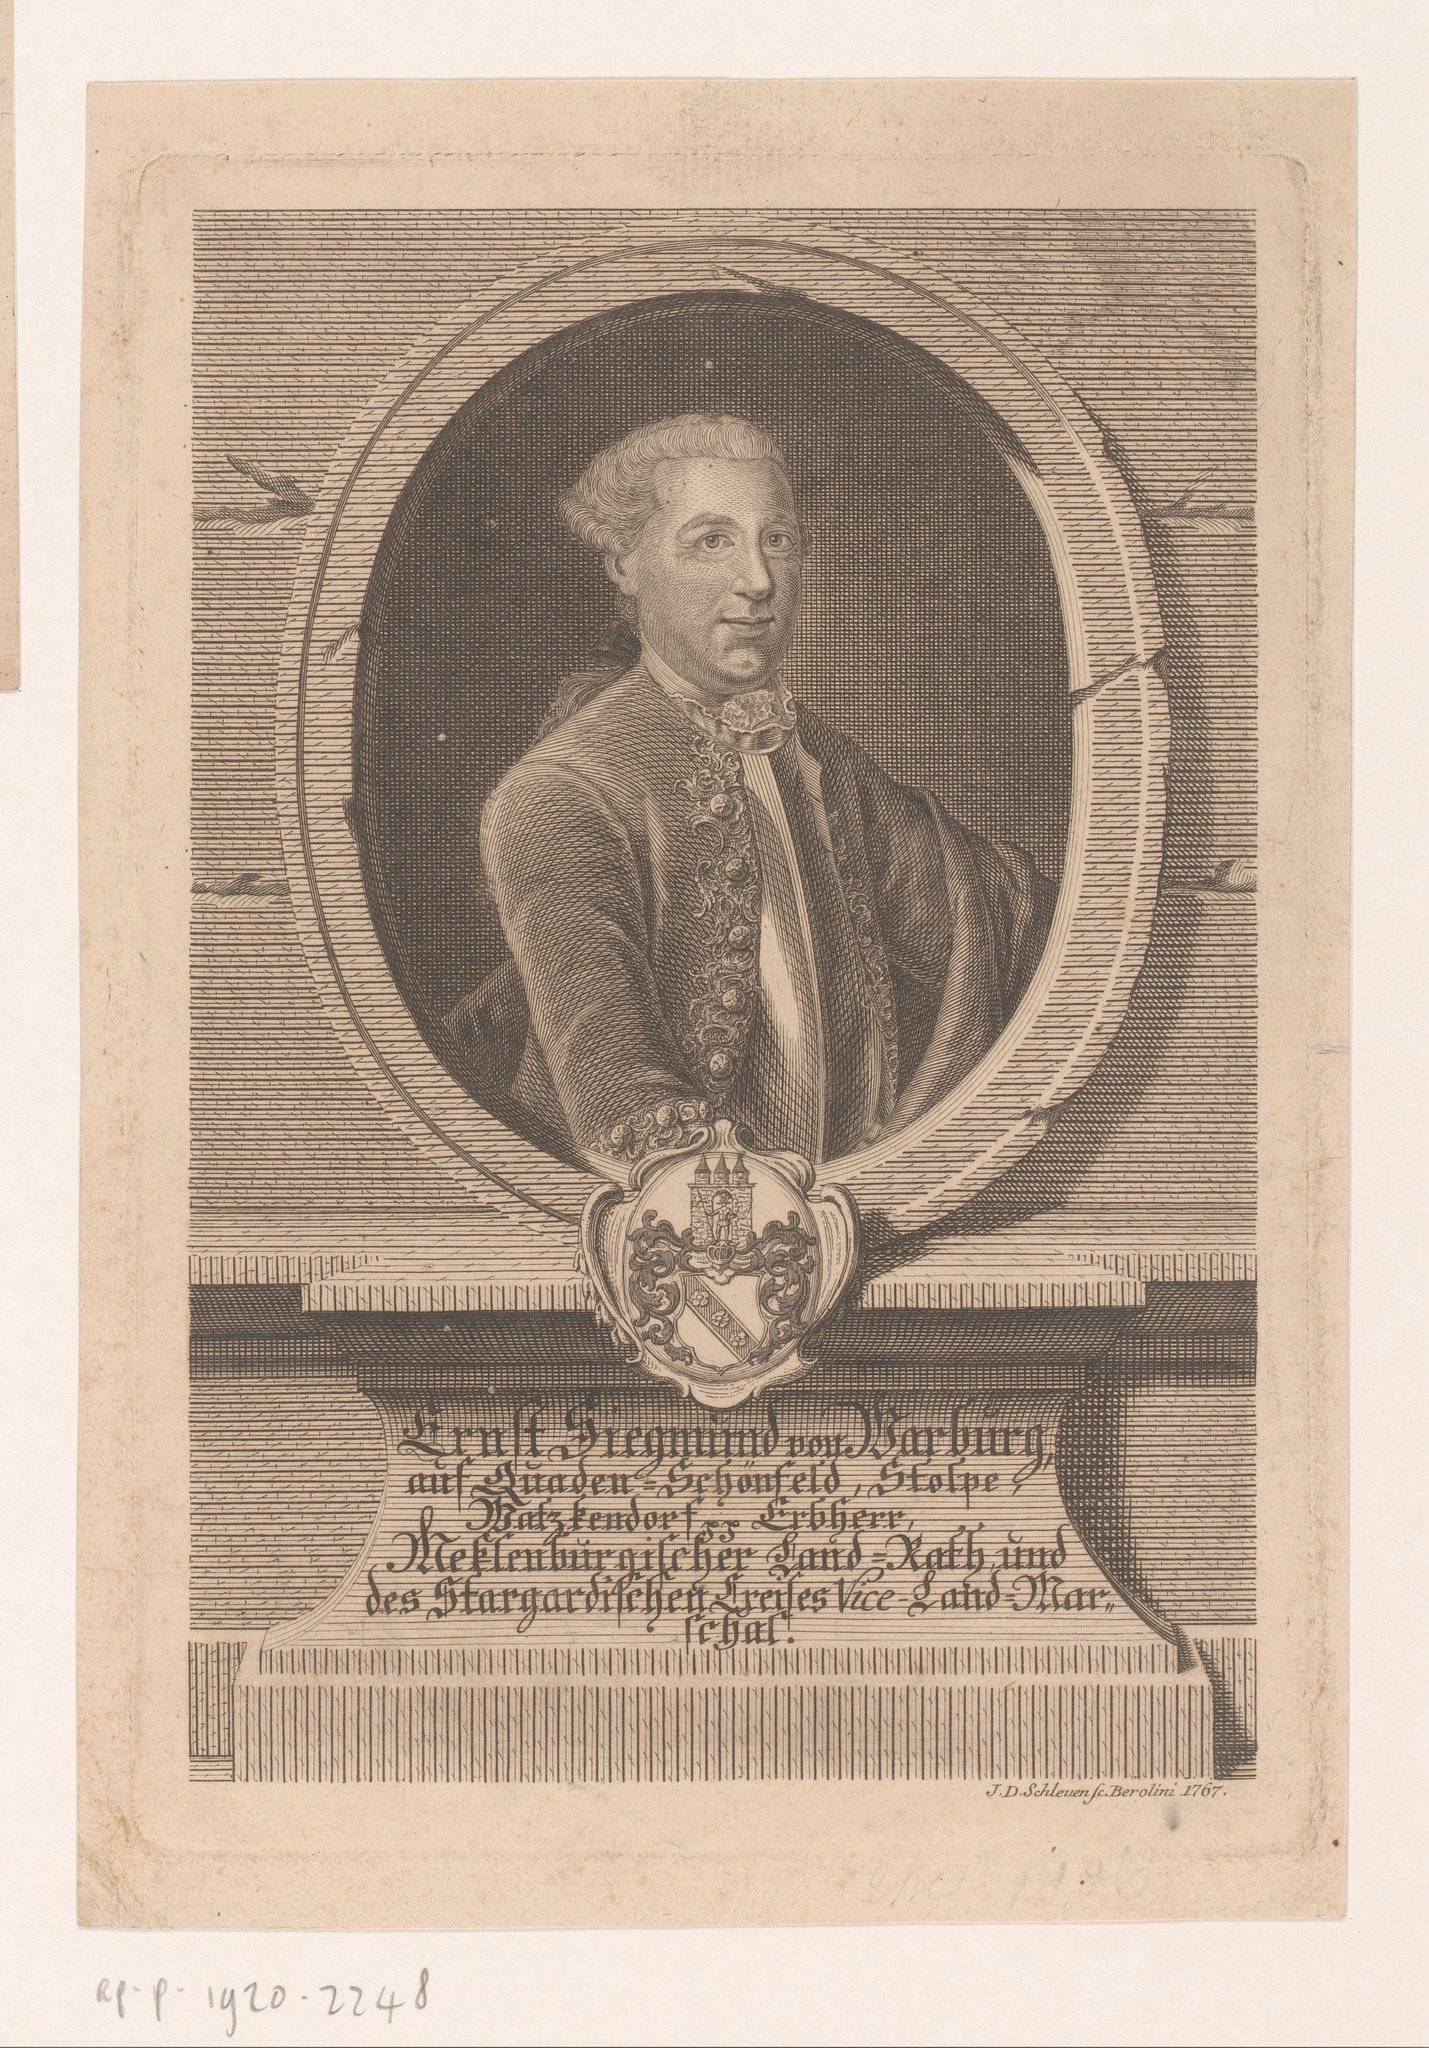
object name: print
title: Portret van Ernst Sigmund de Warburg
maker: johann david schleuen (i)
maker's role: print maker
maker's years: 1711-1774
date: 1767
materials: paper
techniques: engraving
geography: berlin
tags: historical persons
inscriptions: collector's mark: Lugt 2228